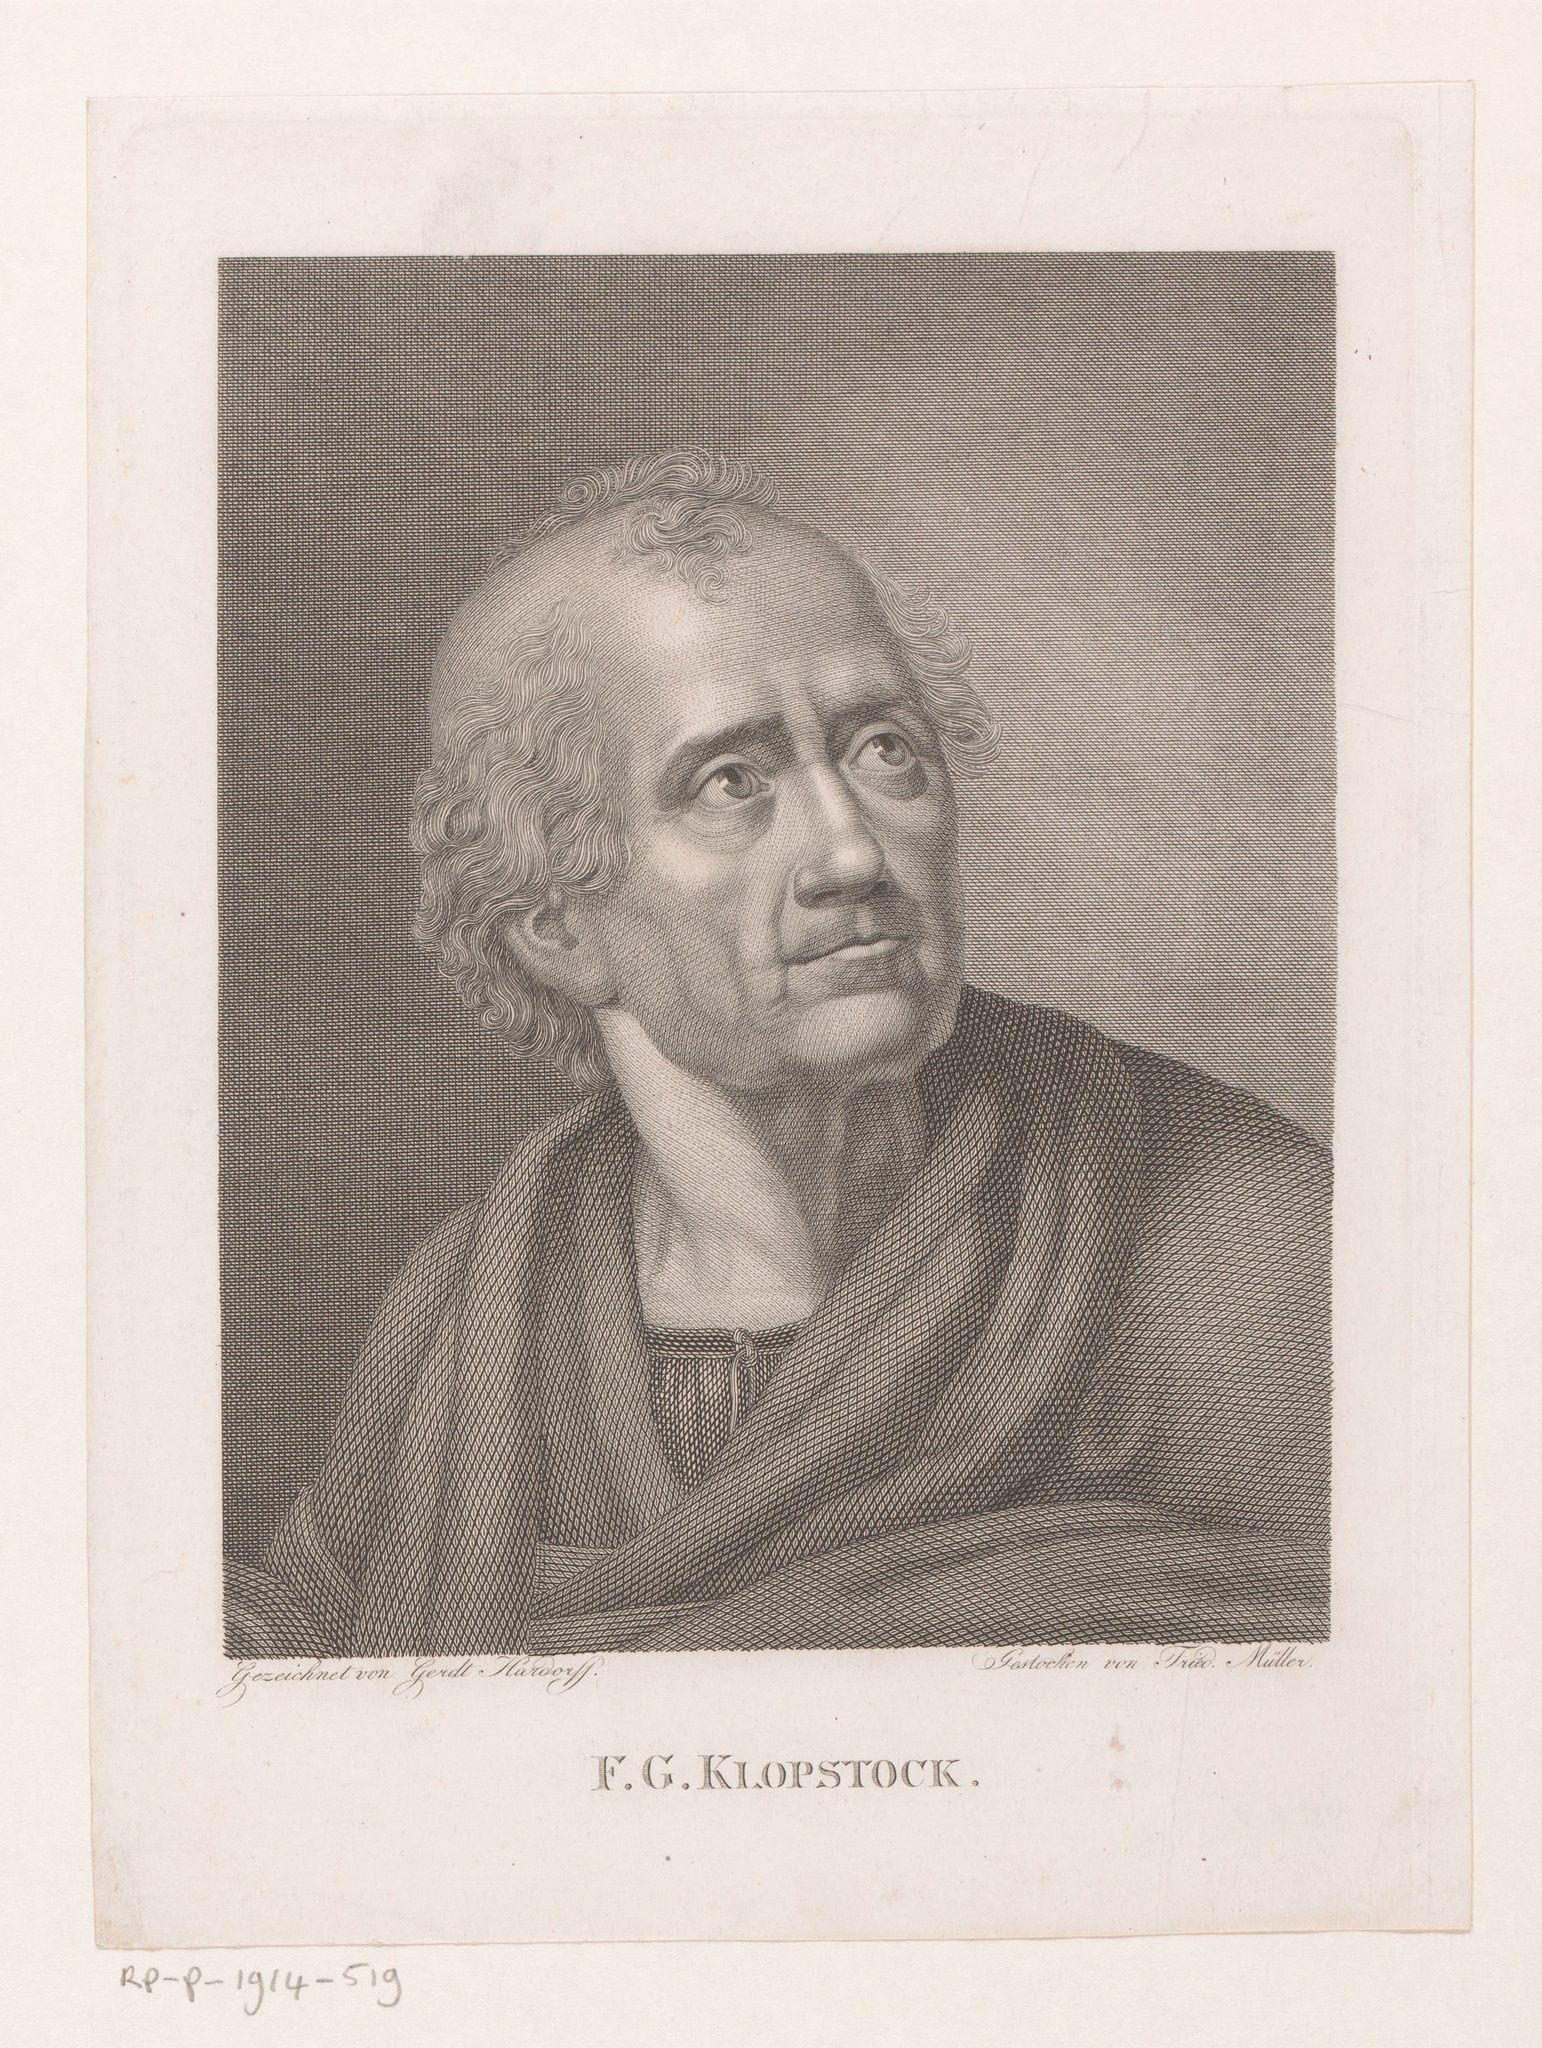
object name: print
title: Portret van Friedrich Gottlieb Klopstock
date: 1792-1816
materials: paper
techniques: engraving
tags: historical persons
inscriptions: collector's mark: Lugt 2228